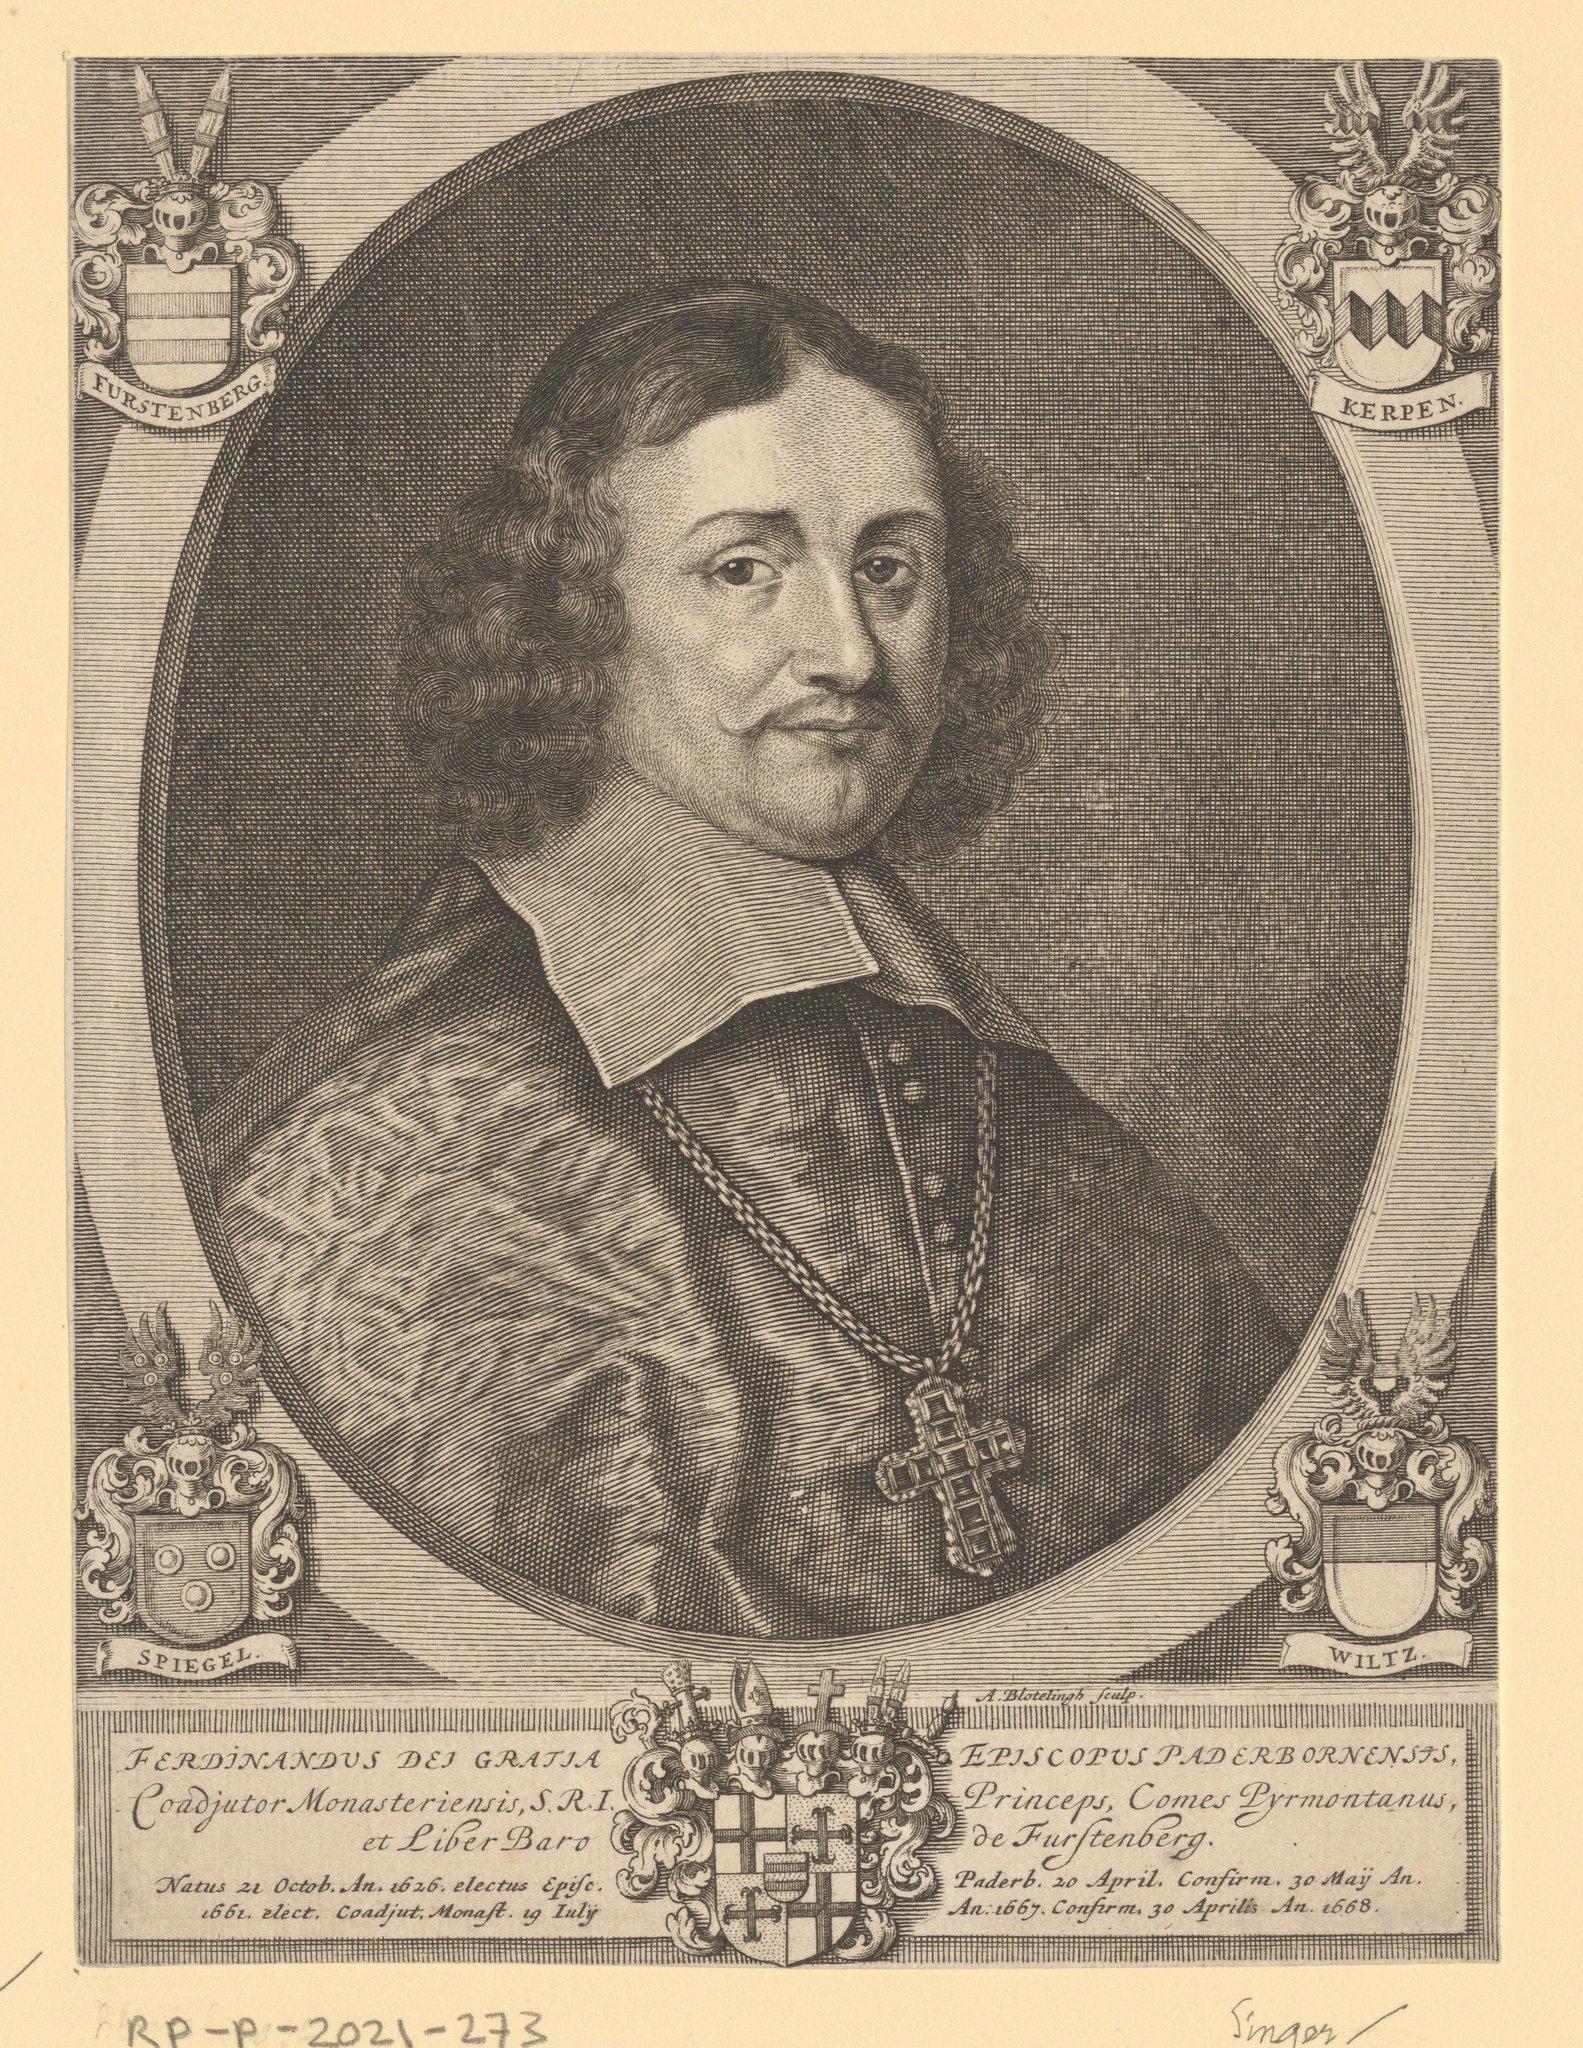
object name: book illustration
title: Portret van Ferdinand von Fürstenberg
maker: abraham bloteling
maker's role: draughtsman, print maker, publisher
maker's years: 1640-1690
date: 1672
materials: paper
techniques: engraving, etching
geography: northern netherlands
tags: ferdinand van fürstenberg, coat of arms (as symbol of the state, etc.), archbishop, bishop, etc. (roman catholic), historical persons, armorial bearing, heraldry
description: Prent waarschijnlijk uit: Fürstenberg, Ferdinand von. Monumenta Paderbornensia ex Historia Romana (...). Amsterdam: Daniel Elsevier, 1672.